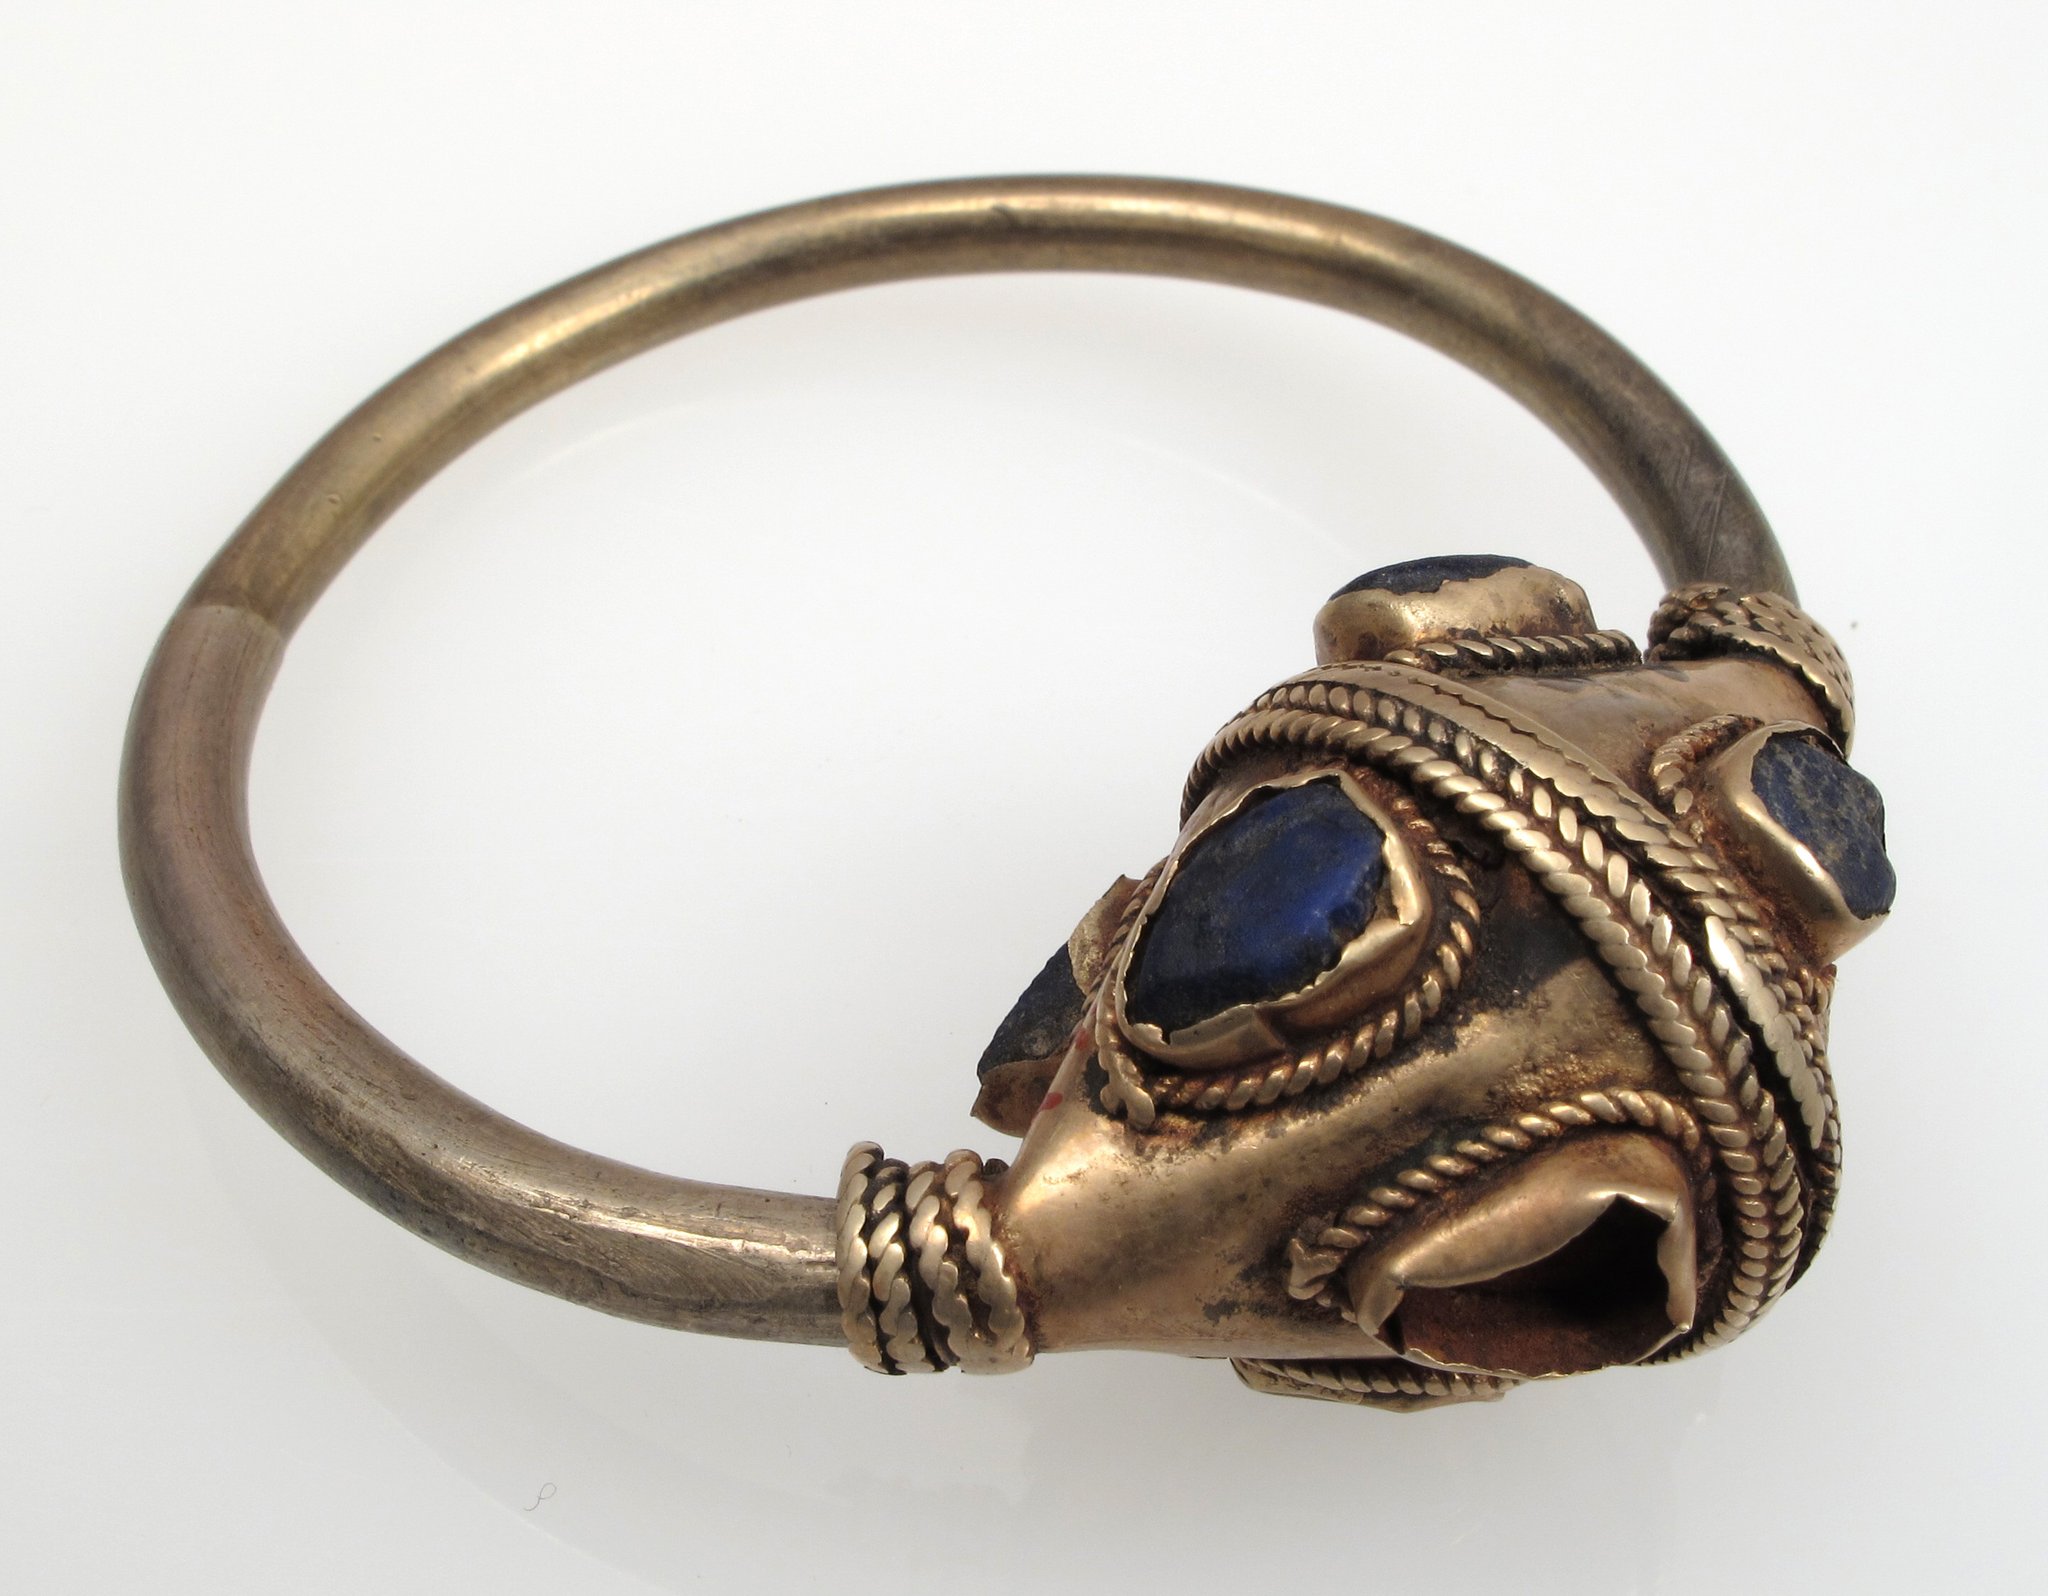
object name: bracelet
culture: east germanic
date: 601-700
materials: glass, silver